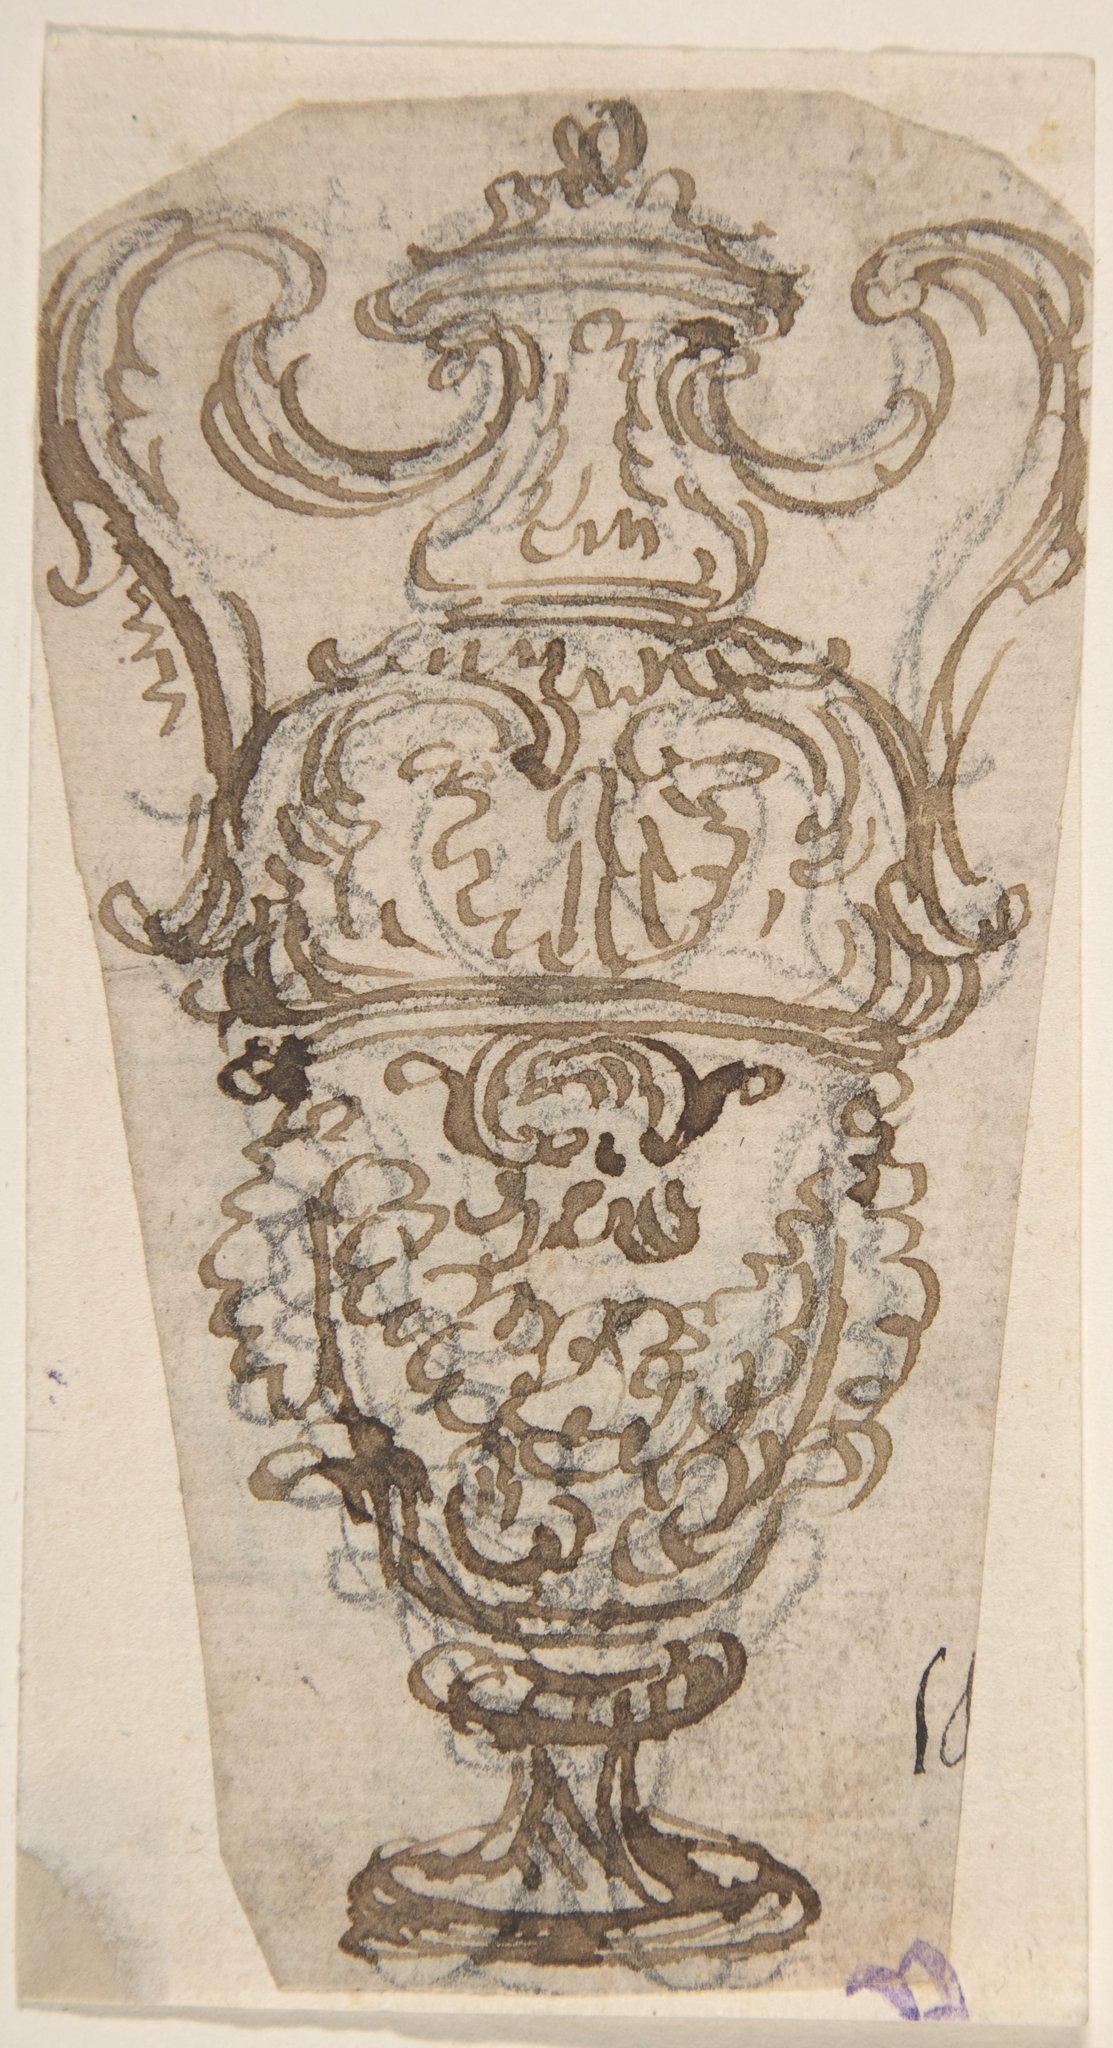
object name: drawing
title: Outline of Design for a Two-Handled Vase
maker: giovanni battista foggini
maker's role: artist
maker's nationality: italian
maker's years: 1652-1725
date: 1672-1725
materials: chalk, ink, paper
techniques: pen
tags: vases